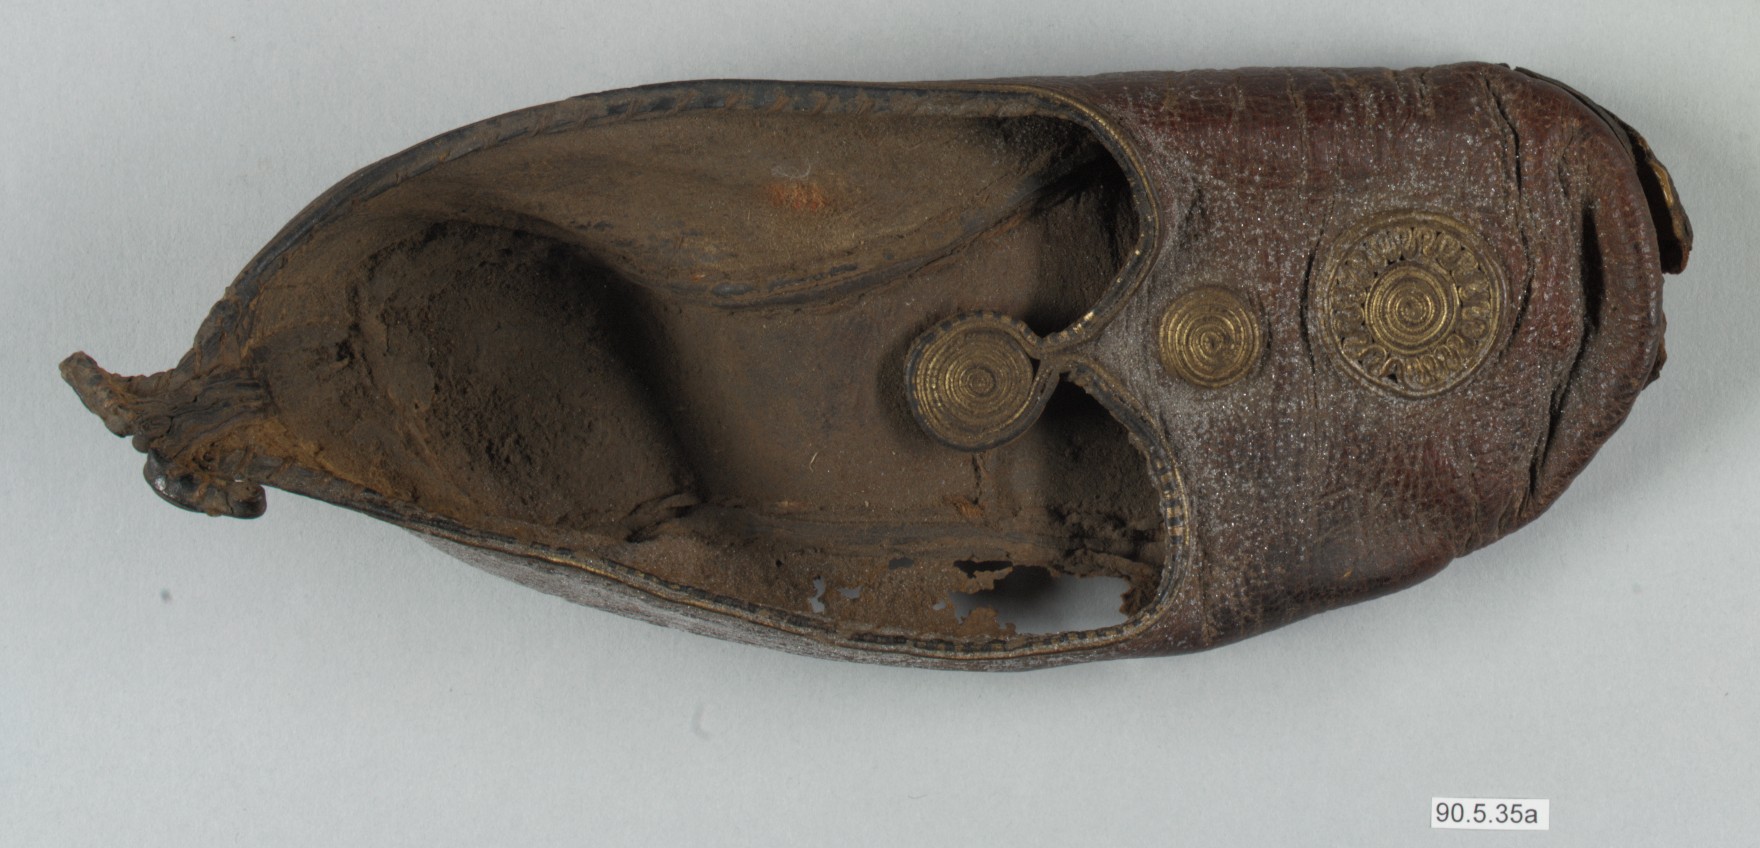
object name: shoe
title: Leather Shoe with Gilded Medallions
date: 101-900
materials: leather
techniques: gilding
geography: egypt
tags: shoes